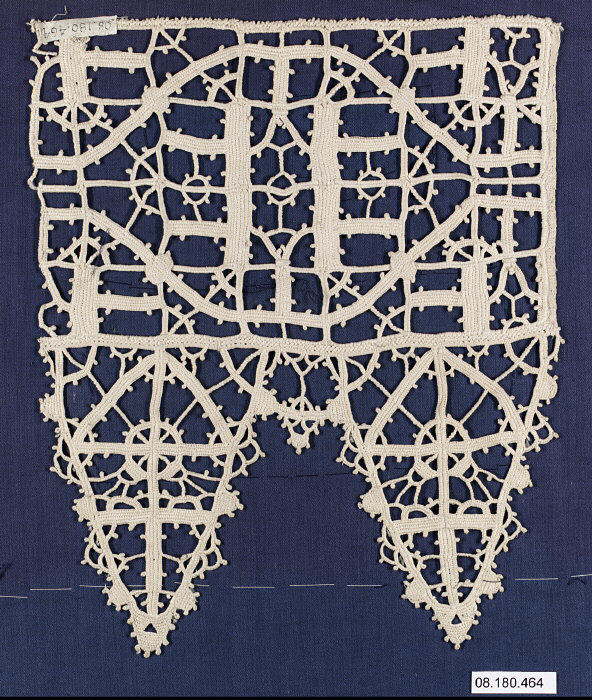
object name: border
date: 1501-1600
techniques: lace